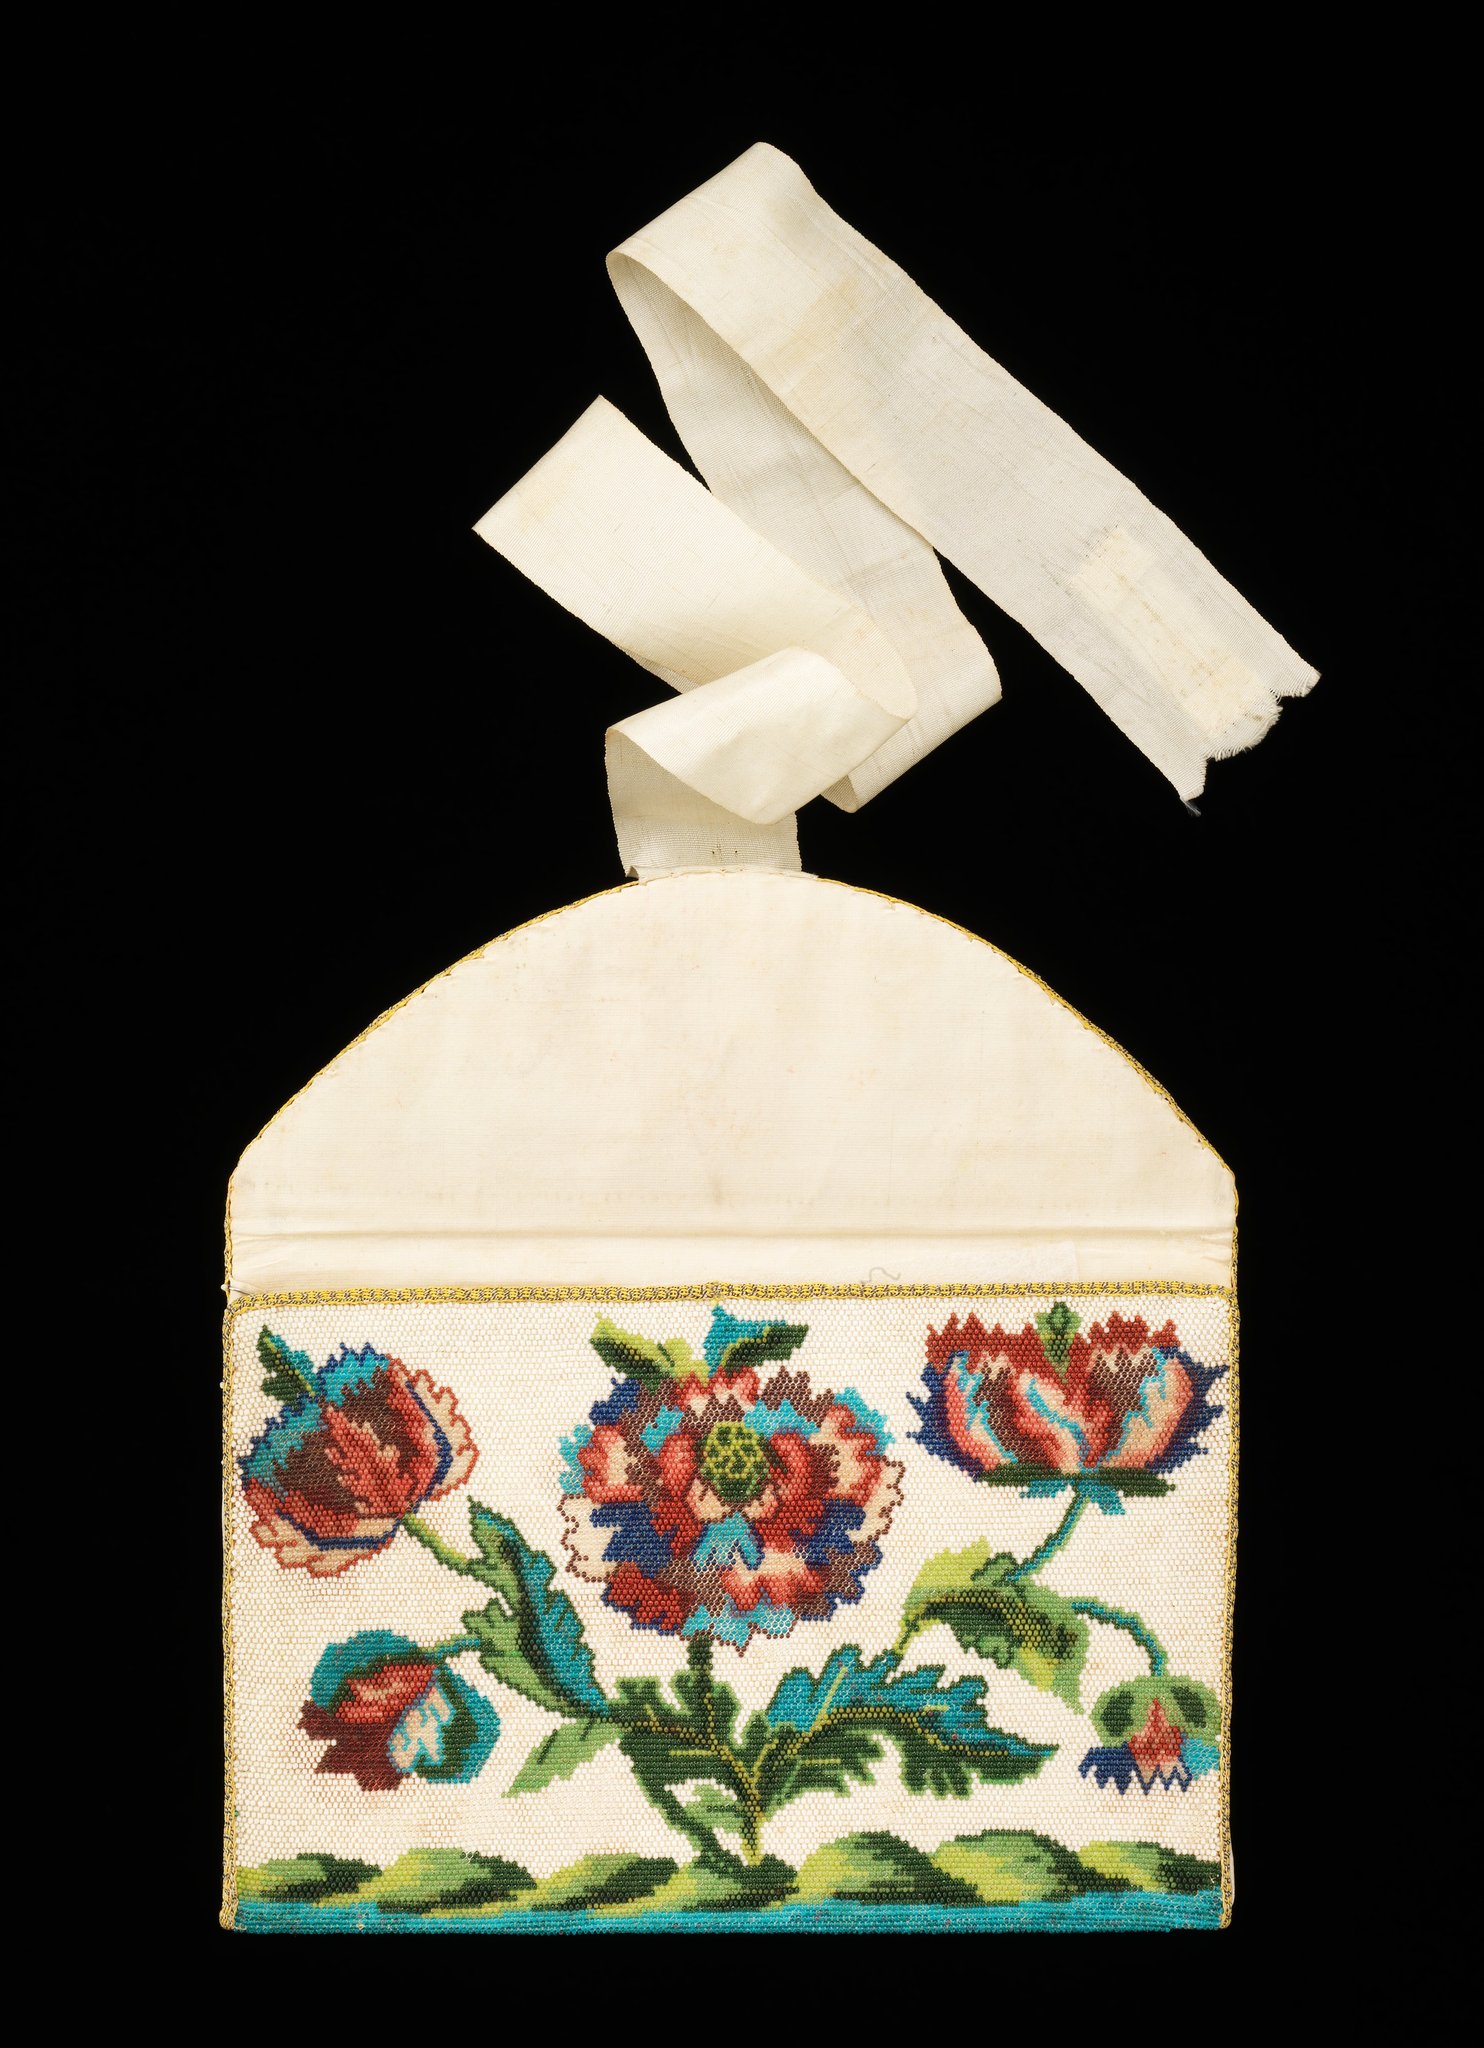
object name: purse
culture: french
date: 1760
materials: glass, silk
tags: flowers